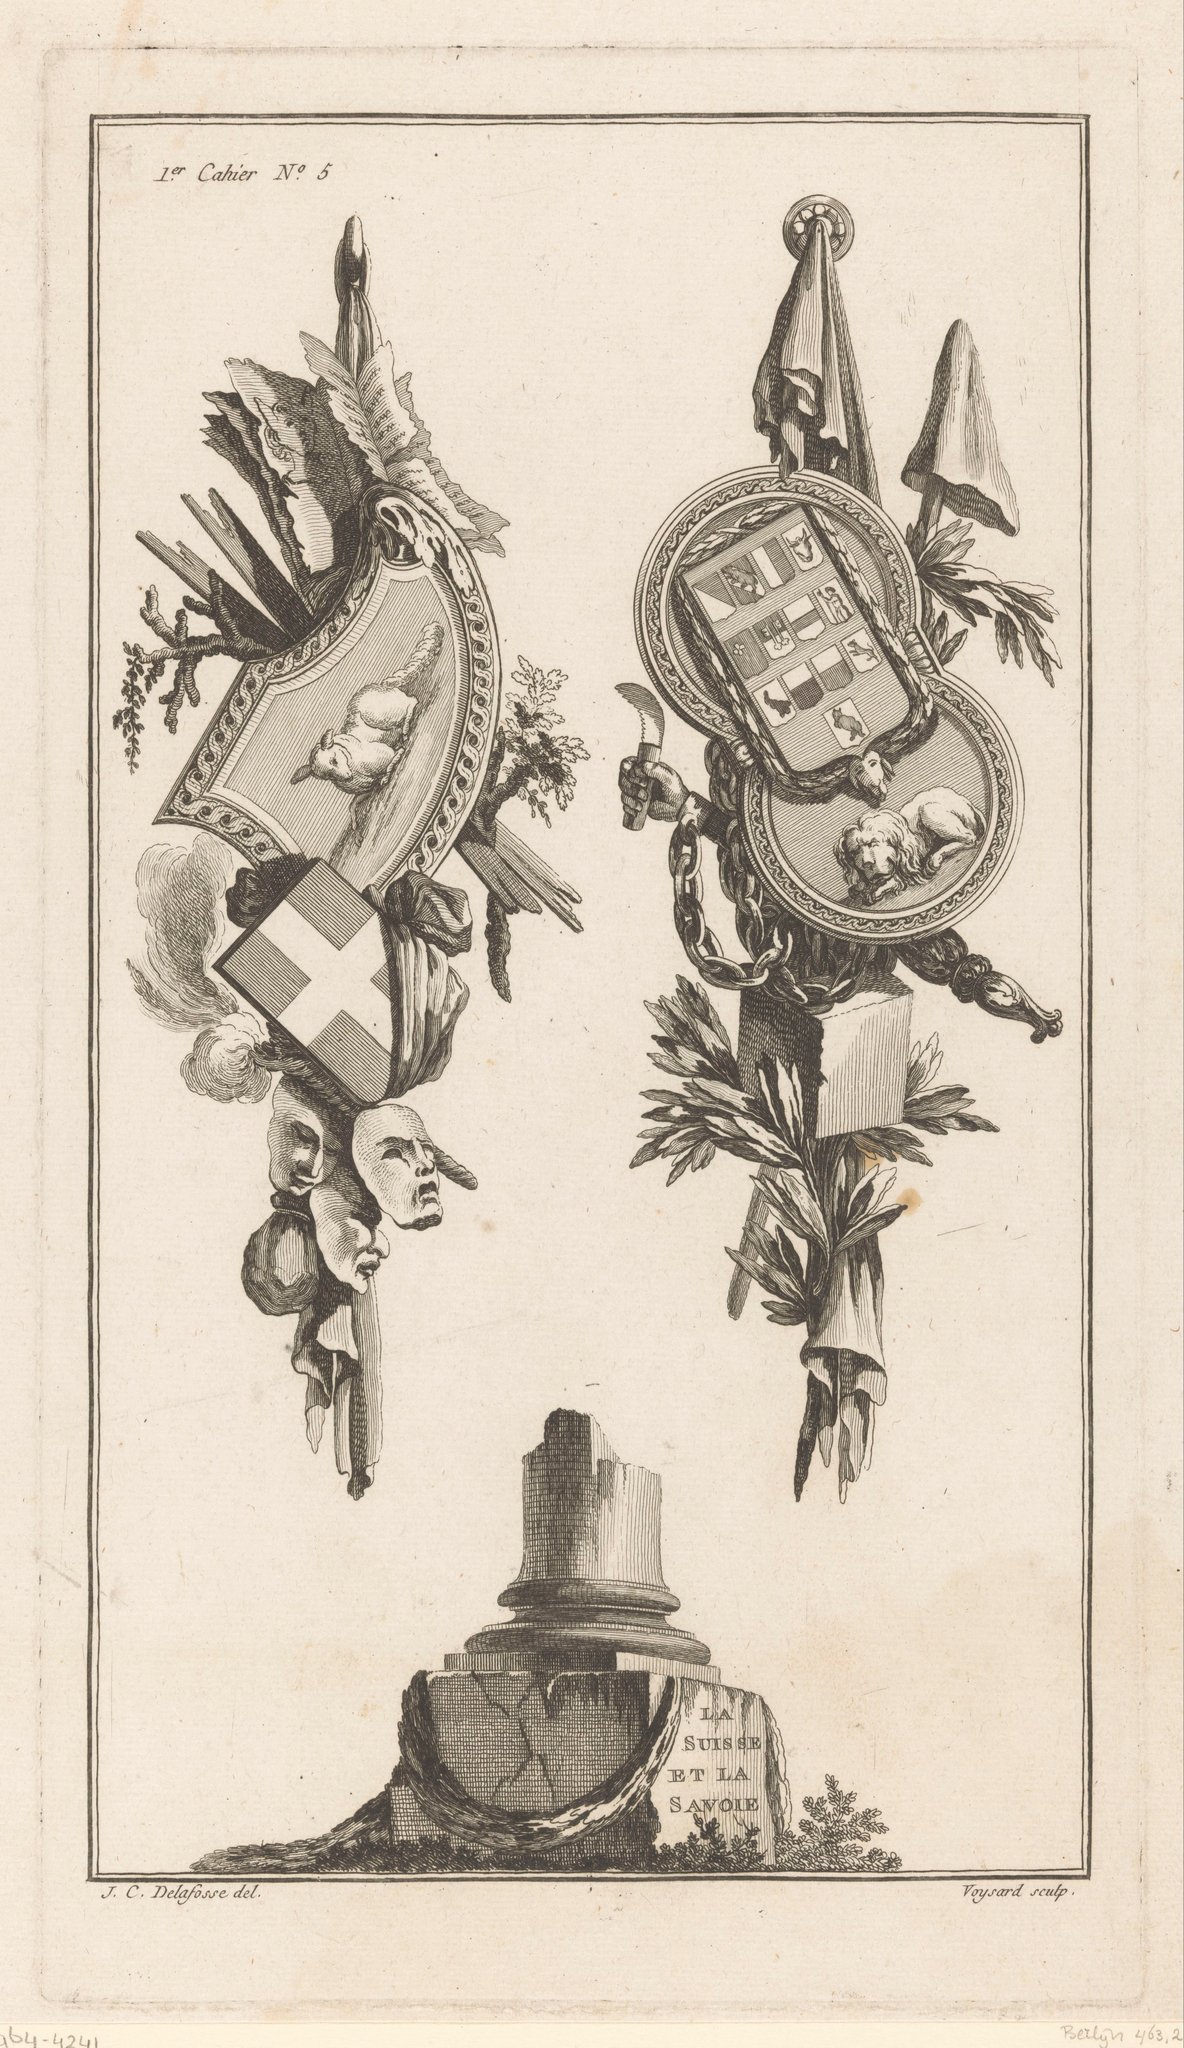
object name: print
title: La Suisse Et La Savoie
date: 1772-1779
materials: paper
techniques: engraving, etching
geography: paris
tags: trophy, i.e.: decorative arrangement of symbolic or typical objects ~ ornament, symbols of particular nations, states, districts, etc., switzerland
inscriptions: collector's mark: Lugt 2760, collector's mark: Lugt 2228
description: Twee trofeeën met schilden. Links met een boek, maskers en een schild met een lam. Rechts met takken en schilden met een leeuw en meerdere wapenschilden.